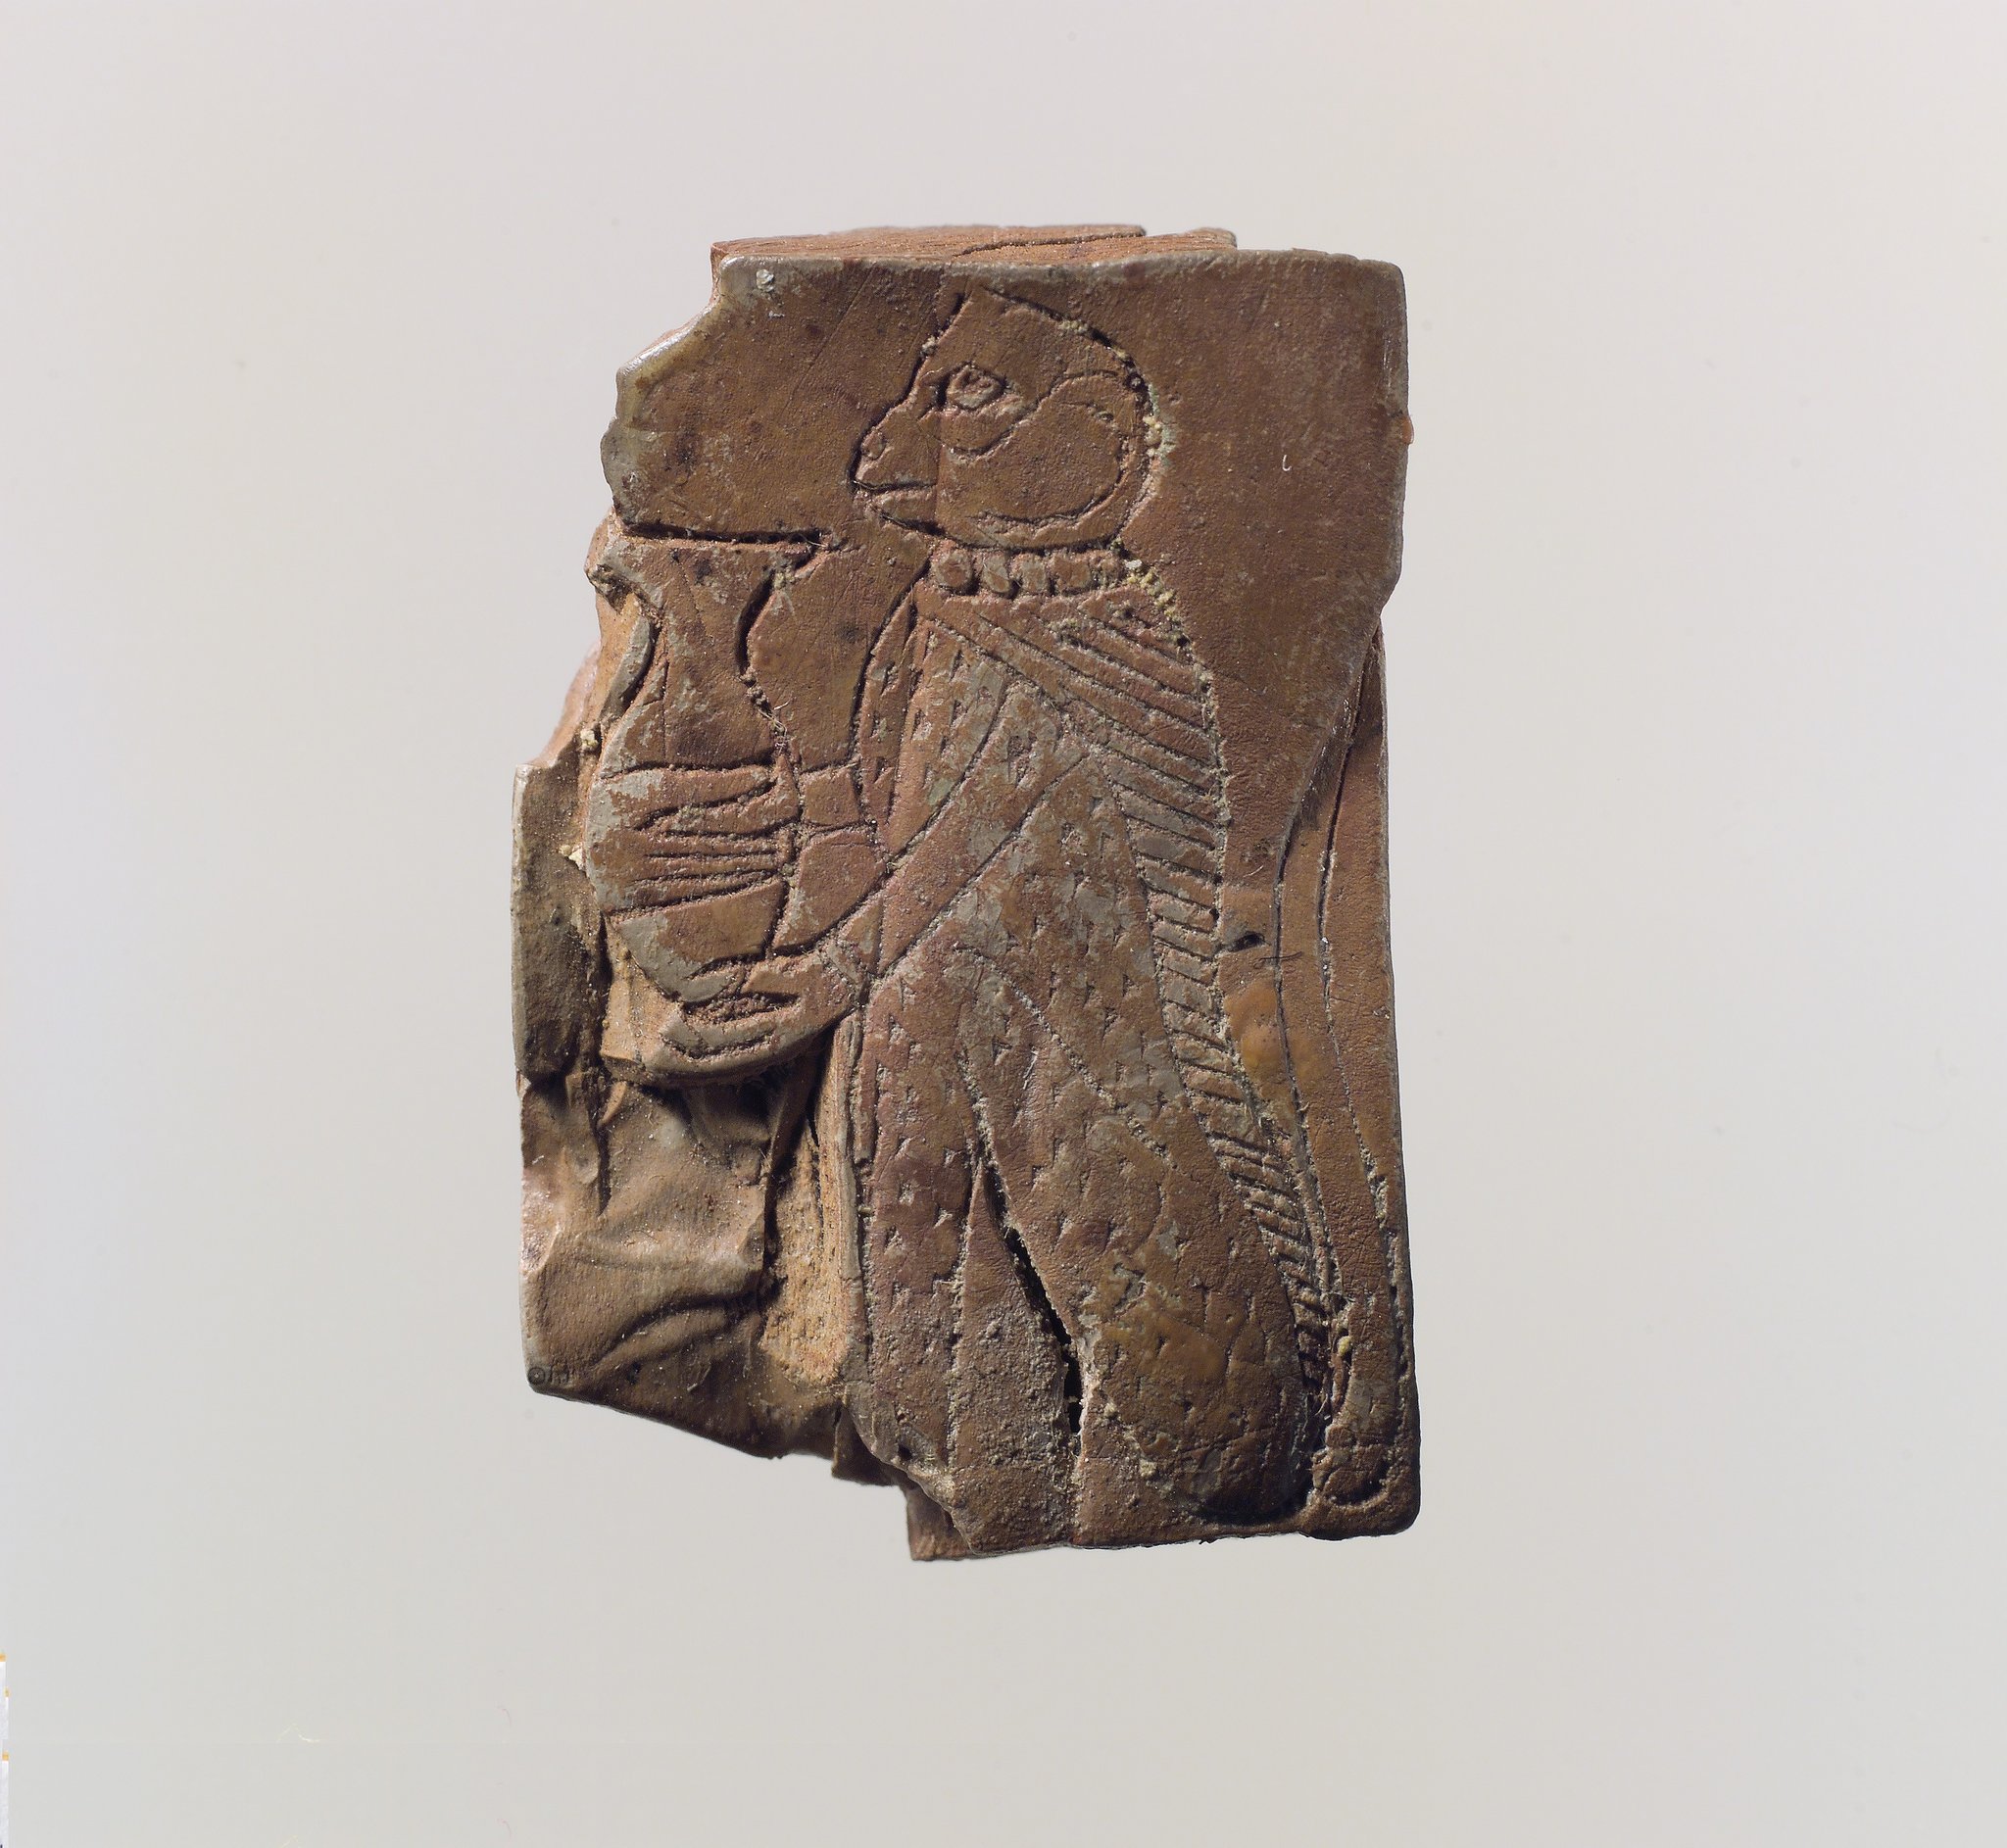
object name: furniture element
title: Furniture element with a monkey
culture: assyrian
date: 1800-1701 BCE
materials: ivory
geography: anatolia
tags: monkeys